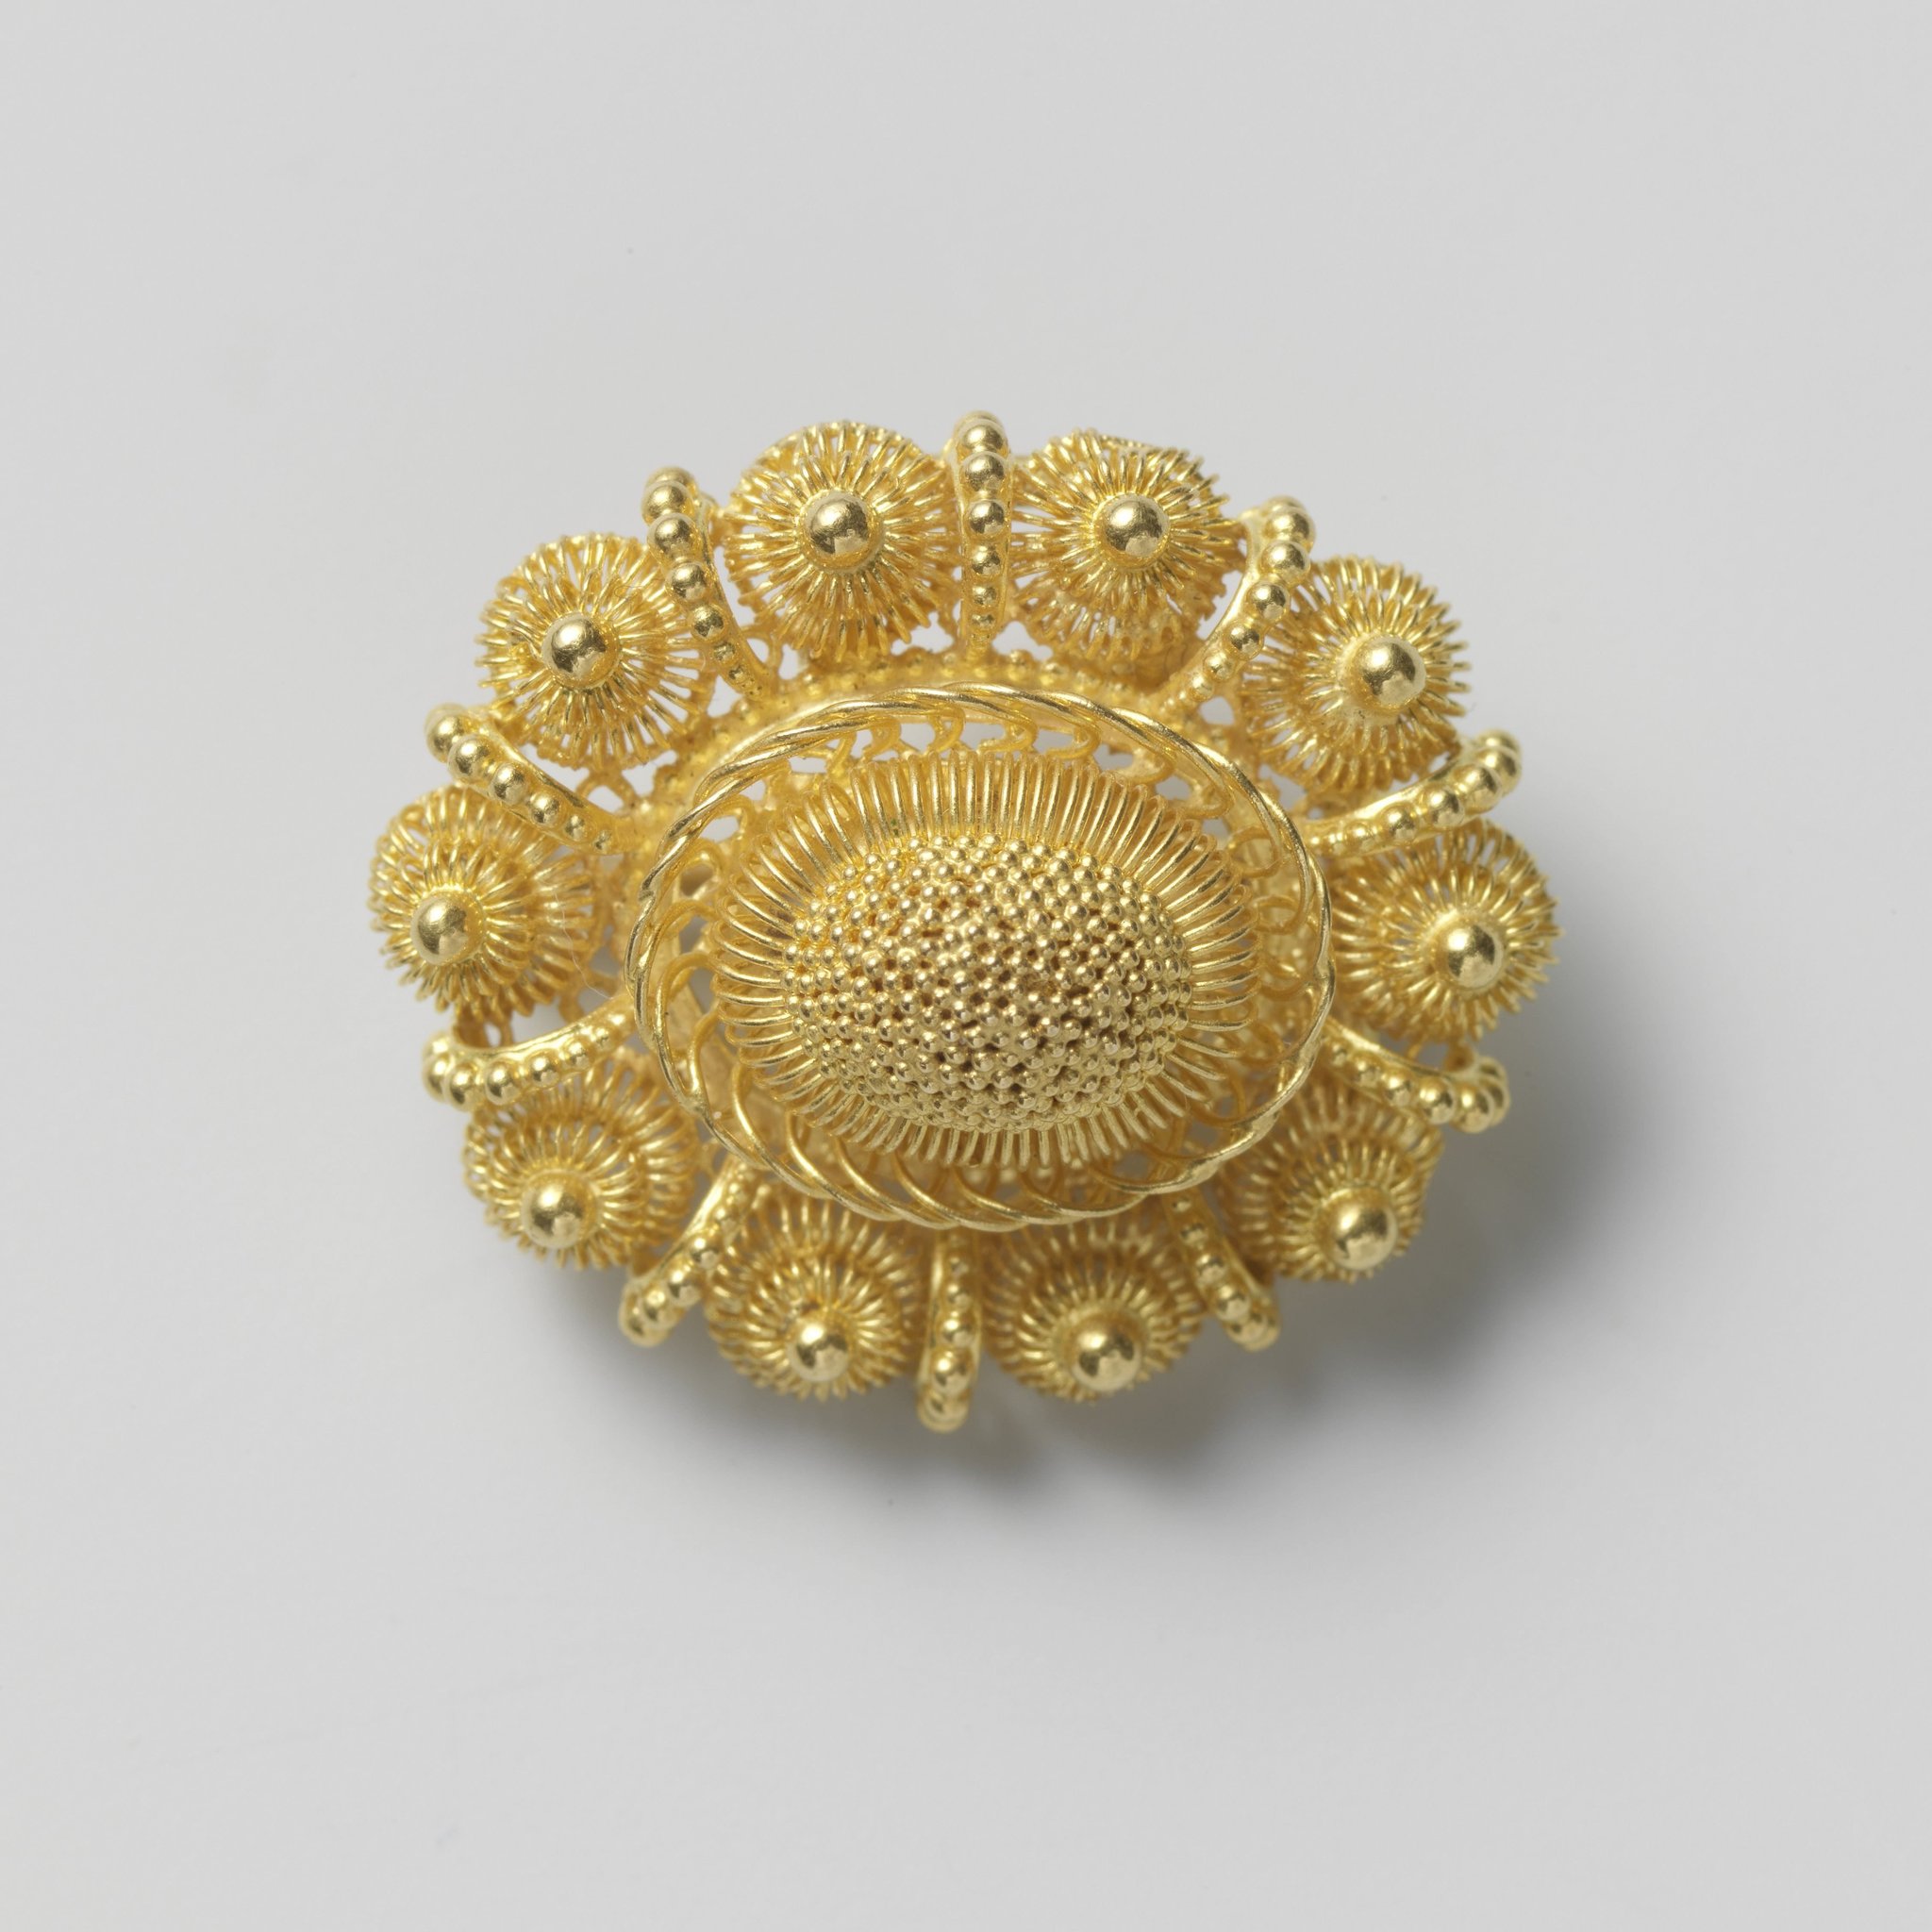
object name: jewellery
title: Broche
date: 1824-1838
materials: gold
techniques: filigree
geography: amsterdam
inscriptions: alloy mark: ‘585 in ovaal (Nederland, vanaf 1955)’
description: Parure. Gold. Amsterdam, c. 1824 - 1838, by Guillaume Louis Ploem, C. Charles Colsoul en Johan Lorenz Holzapfel.